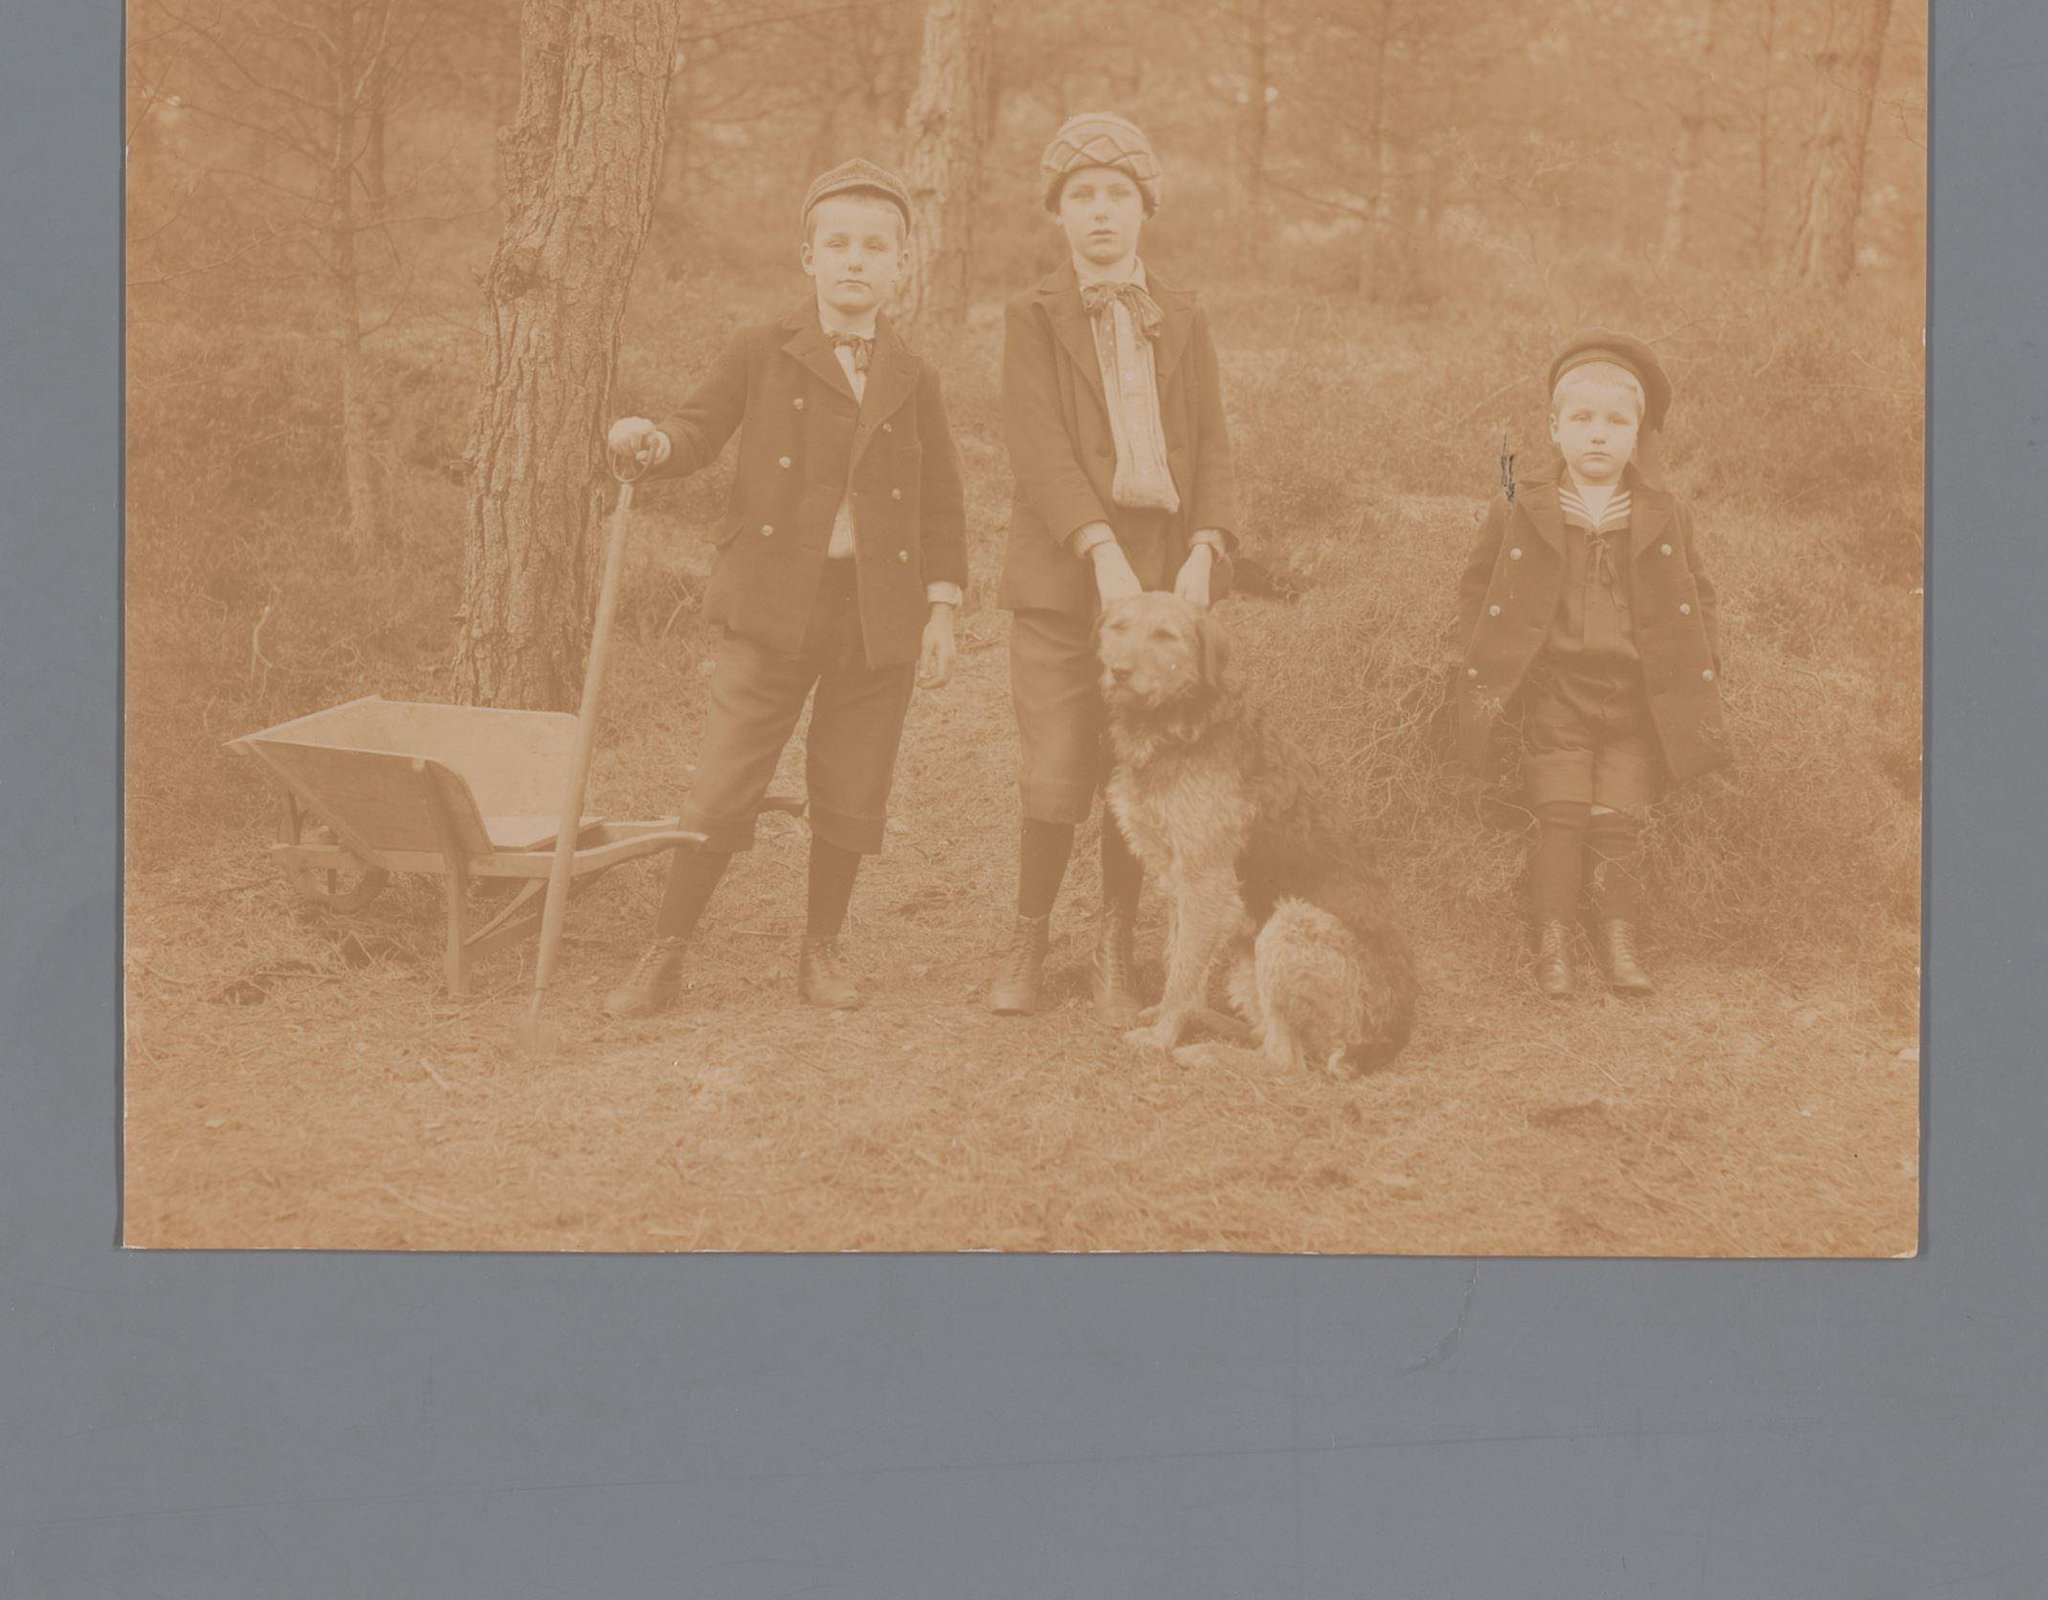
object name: photograph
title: Groepsportret van Lucas, Willem en Goverdus Henricus Jonker met een hond in het bos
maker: cornelia hendrika jonker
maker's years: 1874-1924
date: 1907-1908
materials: photographic support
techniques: gelatin silver print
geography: hattem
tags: forest, wood, dog, anonymous historical persons portrayed in a group, in a group-portrait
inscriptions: annotation: ‘'t Velt-huys Hattem/ winter 1907/08/ Pim, Luuk, Hein’